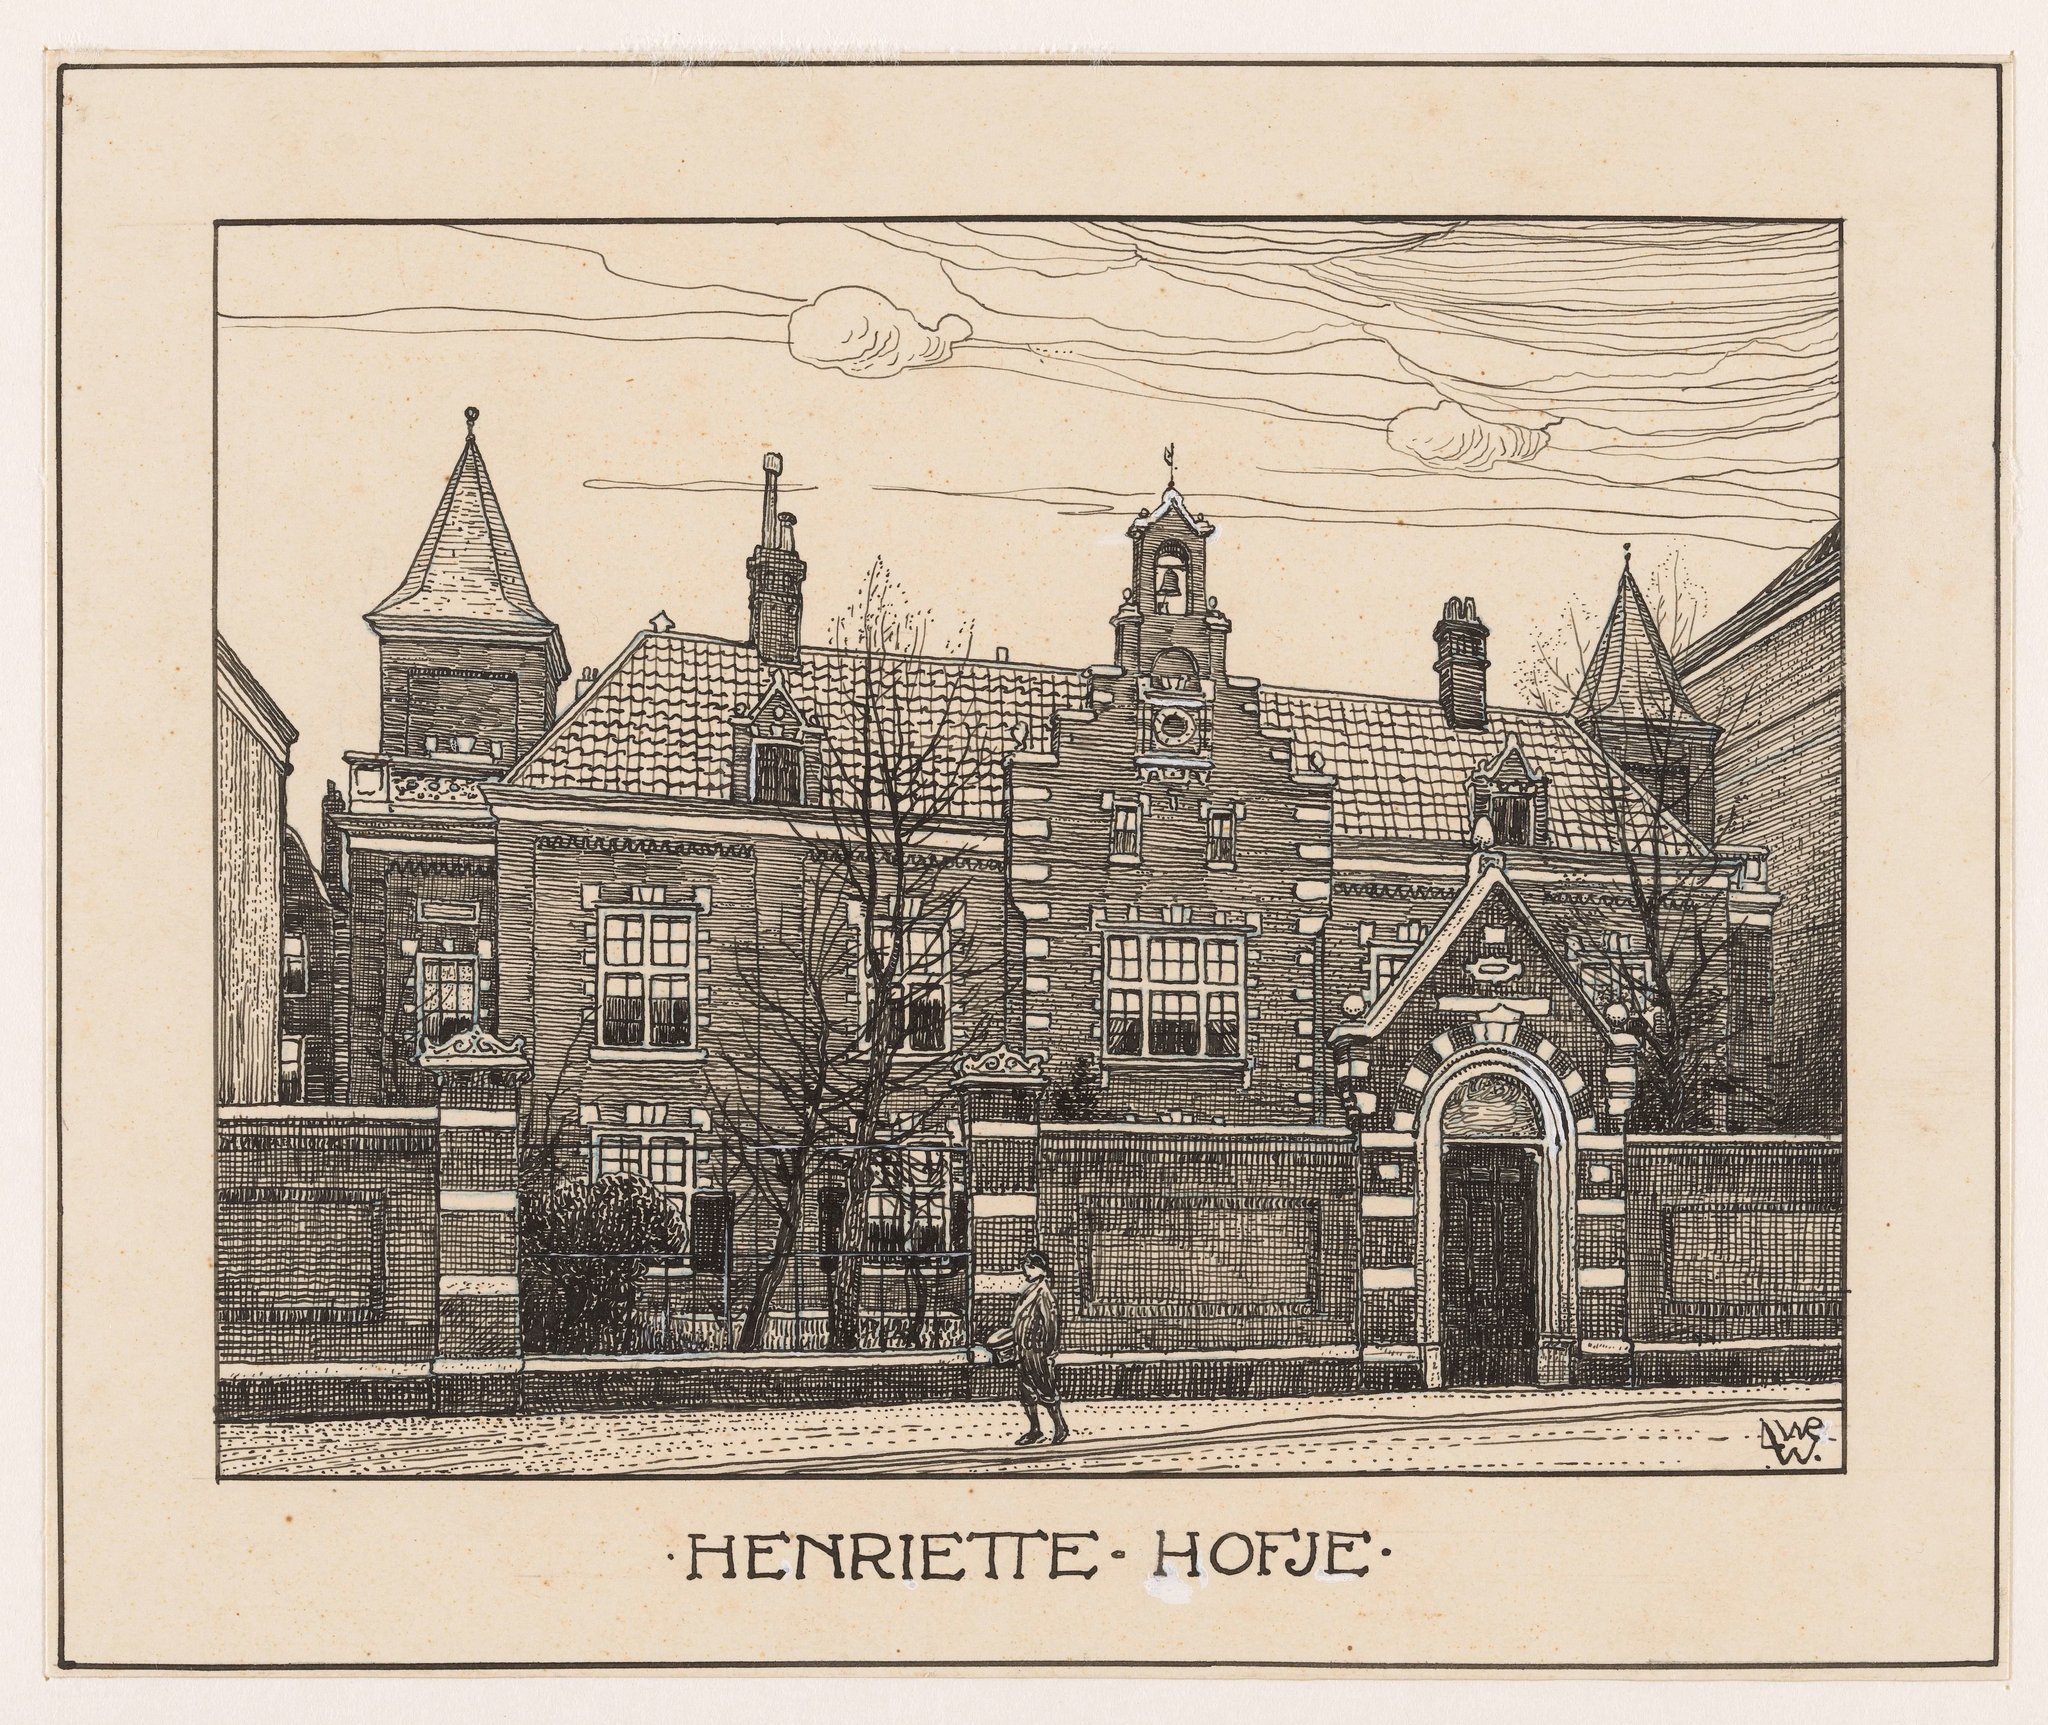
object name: drawing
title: Het Henriette Hofje aan de Stadhouderskade te Amsterdam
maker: willem wenckebach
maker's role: designer, draughtsman, painter, print maker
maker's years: 1860-1937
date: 1870-1926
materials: paint, ink, paper, pencil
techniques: pen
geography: amsterdam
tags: alms-house (dutch: 'hofje'), amsterdam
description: Het Henriette Hofje aan de Stadhouderskade te Amsterdam, gebouwd in 1869 door Tetar van Elven.